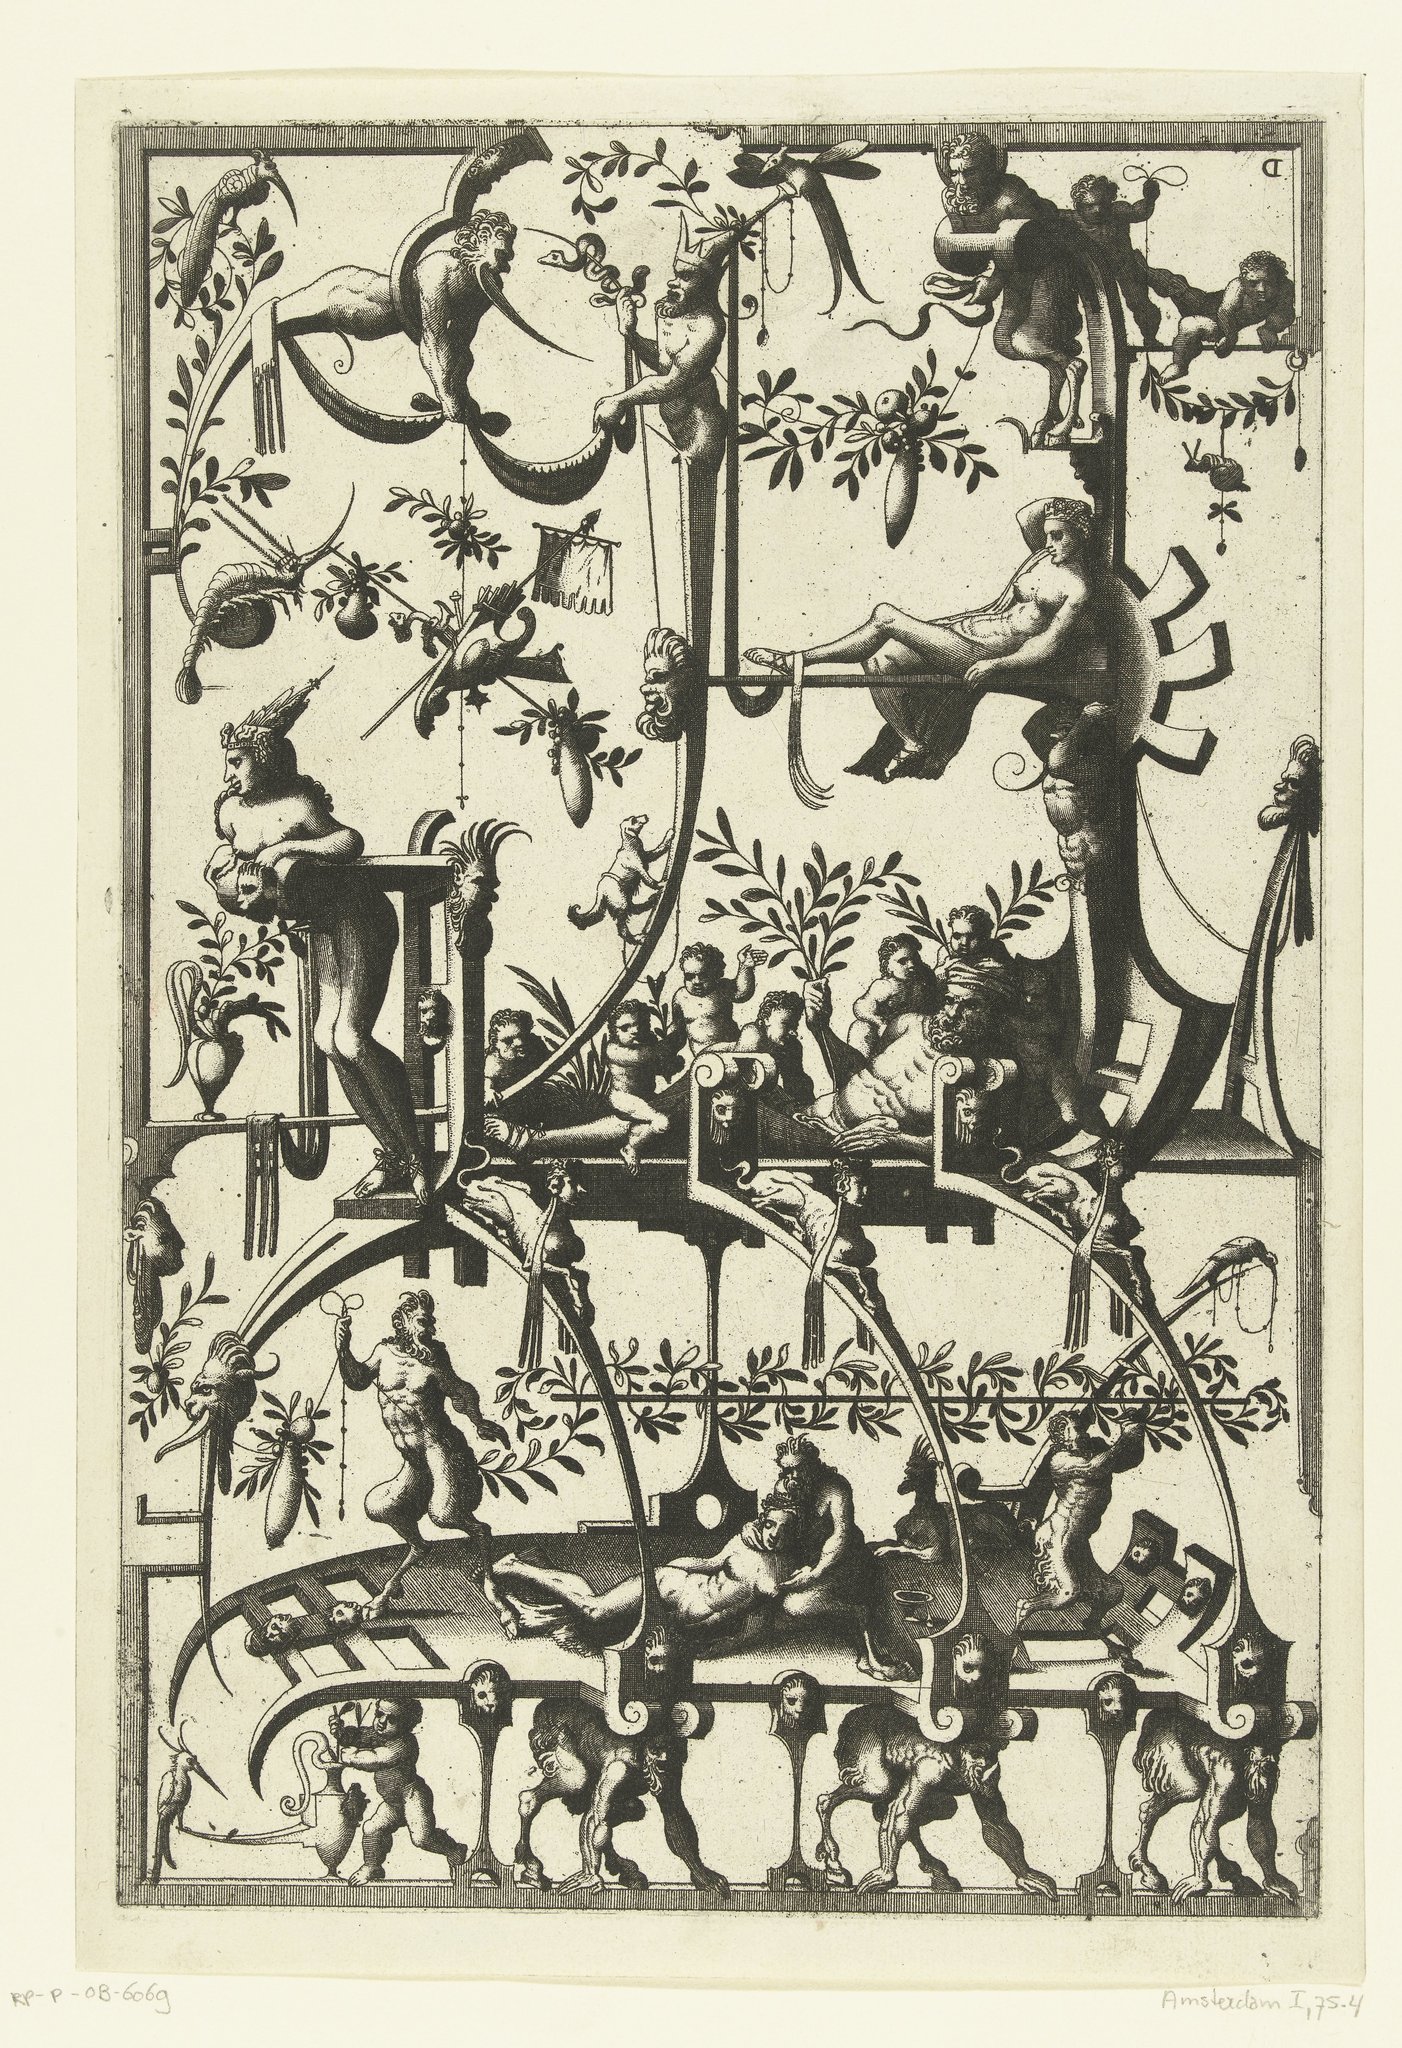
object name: ornament print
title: Veelderleij Veranderinghe van grotissen ende Compertimenten (...)Libro Primo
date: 1556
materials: paper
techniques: etching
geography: netherlands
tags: ornament ~ grotesque, satyr(s) (in general)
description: Op het onderste niveau liggen een sater en een bacchante, daarboven ligt een god omringd door kindertjes. Blad D uit serie van 12 bladen, genummerd A-M met vlakdecoraties van grotesken met rolwerk, saters, guirlandes, trofeeën, dieren en fantasiewezens.